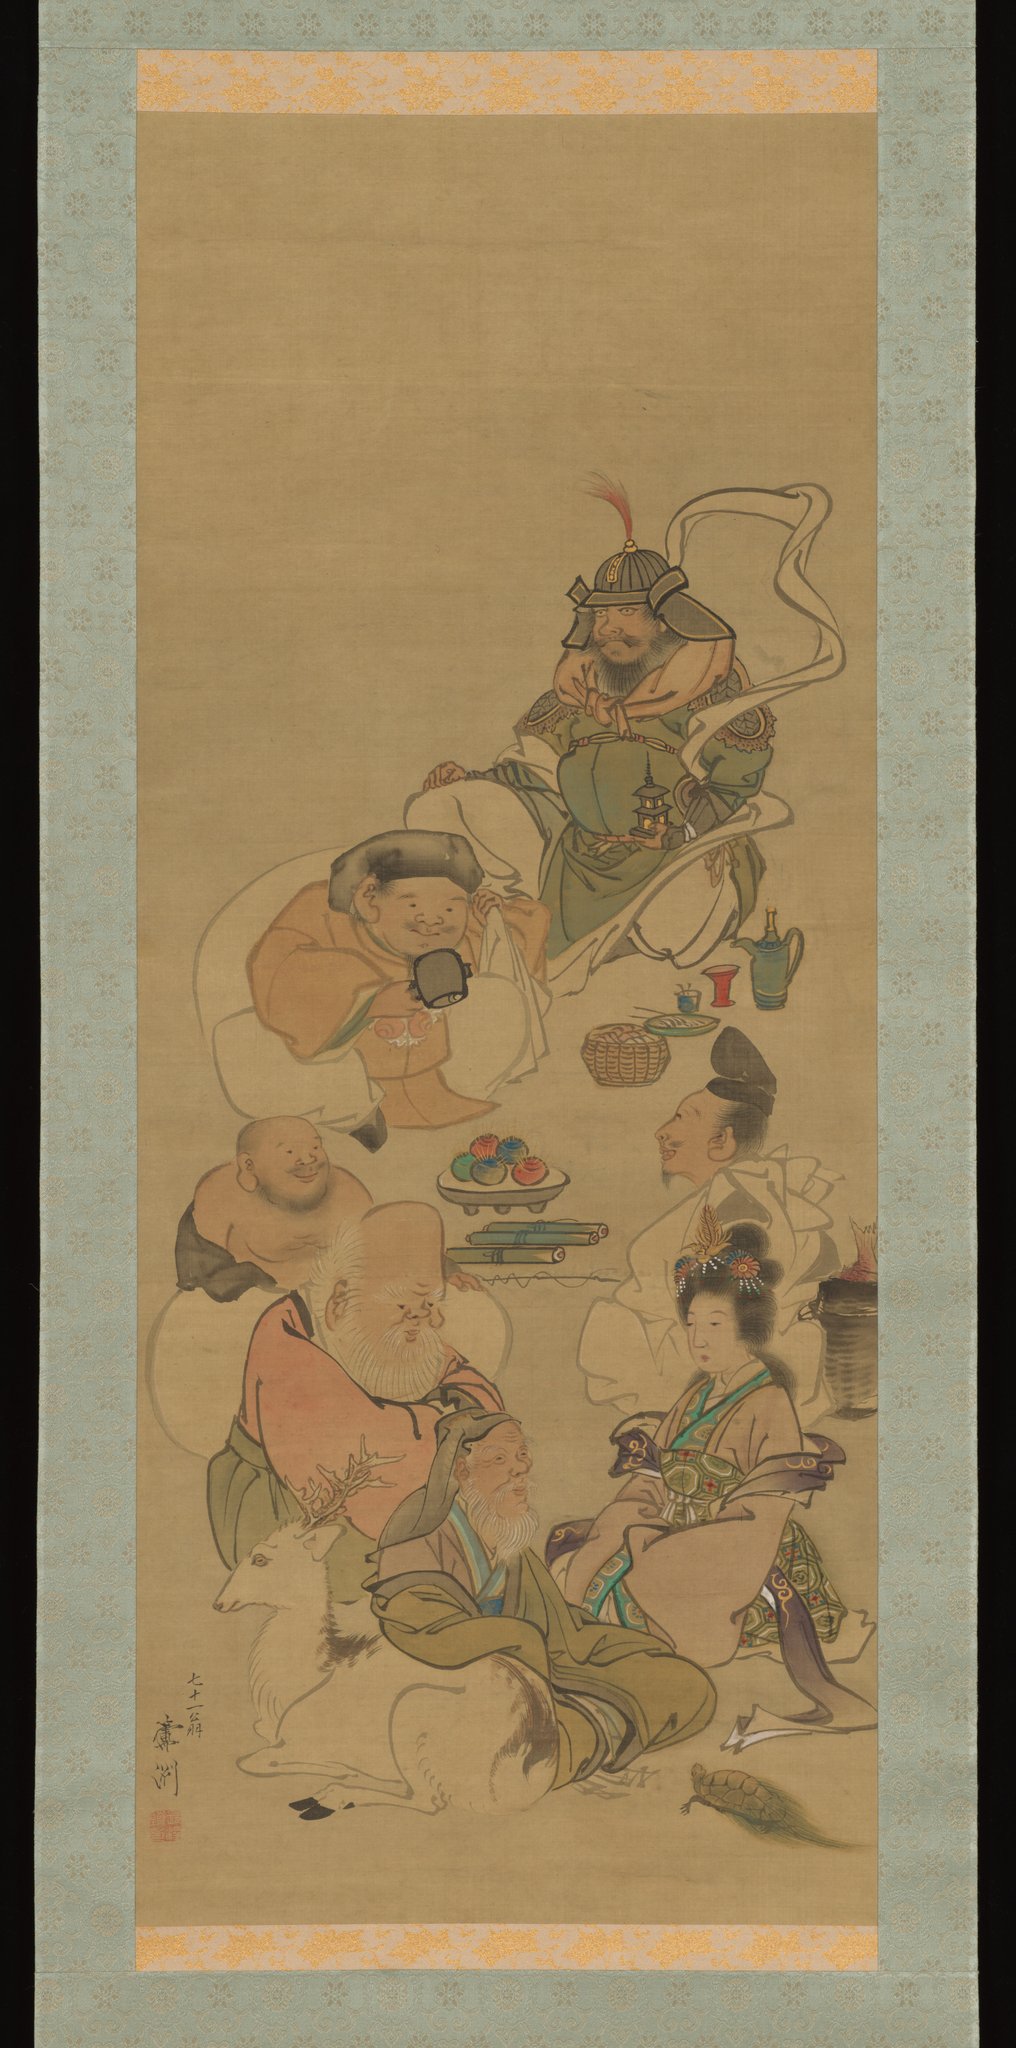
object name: hanging scroll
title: Seven Gods of Good Fortune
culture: japanese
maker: nagasawa roshū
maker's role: artist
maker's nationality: japanese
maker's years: 1767-1847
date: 1837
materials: ink, silk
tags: men,women,deer